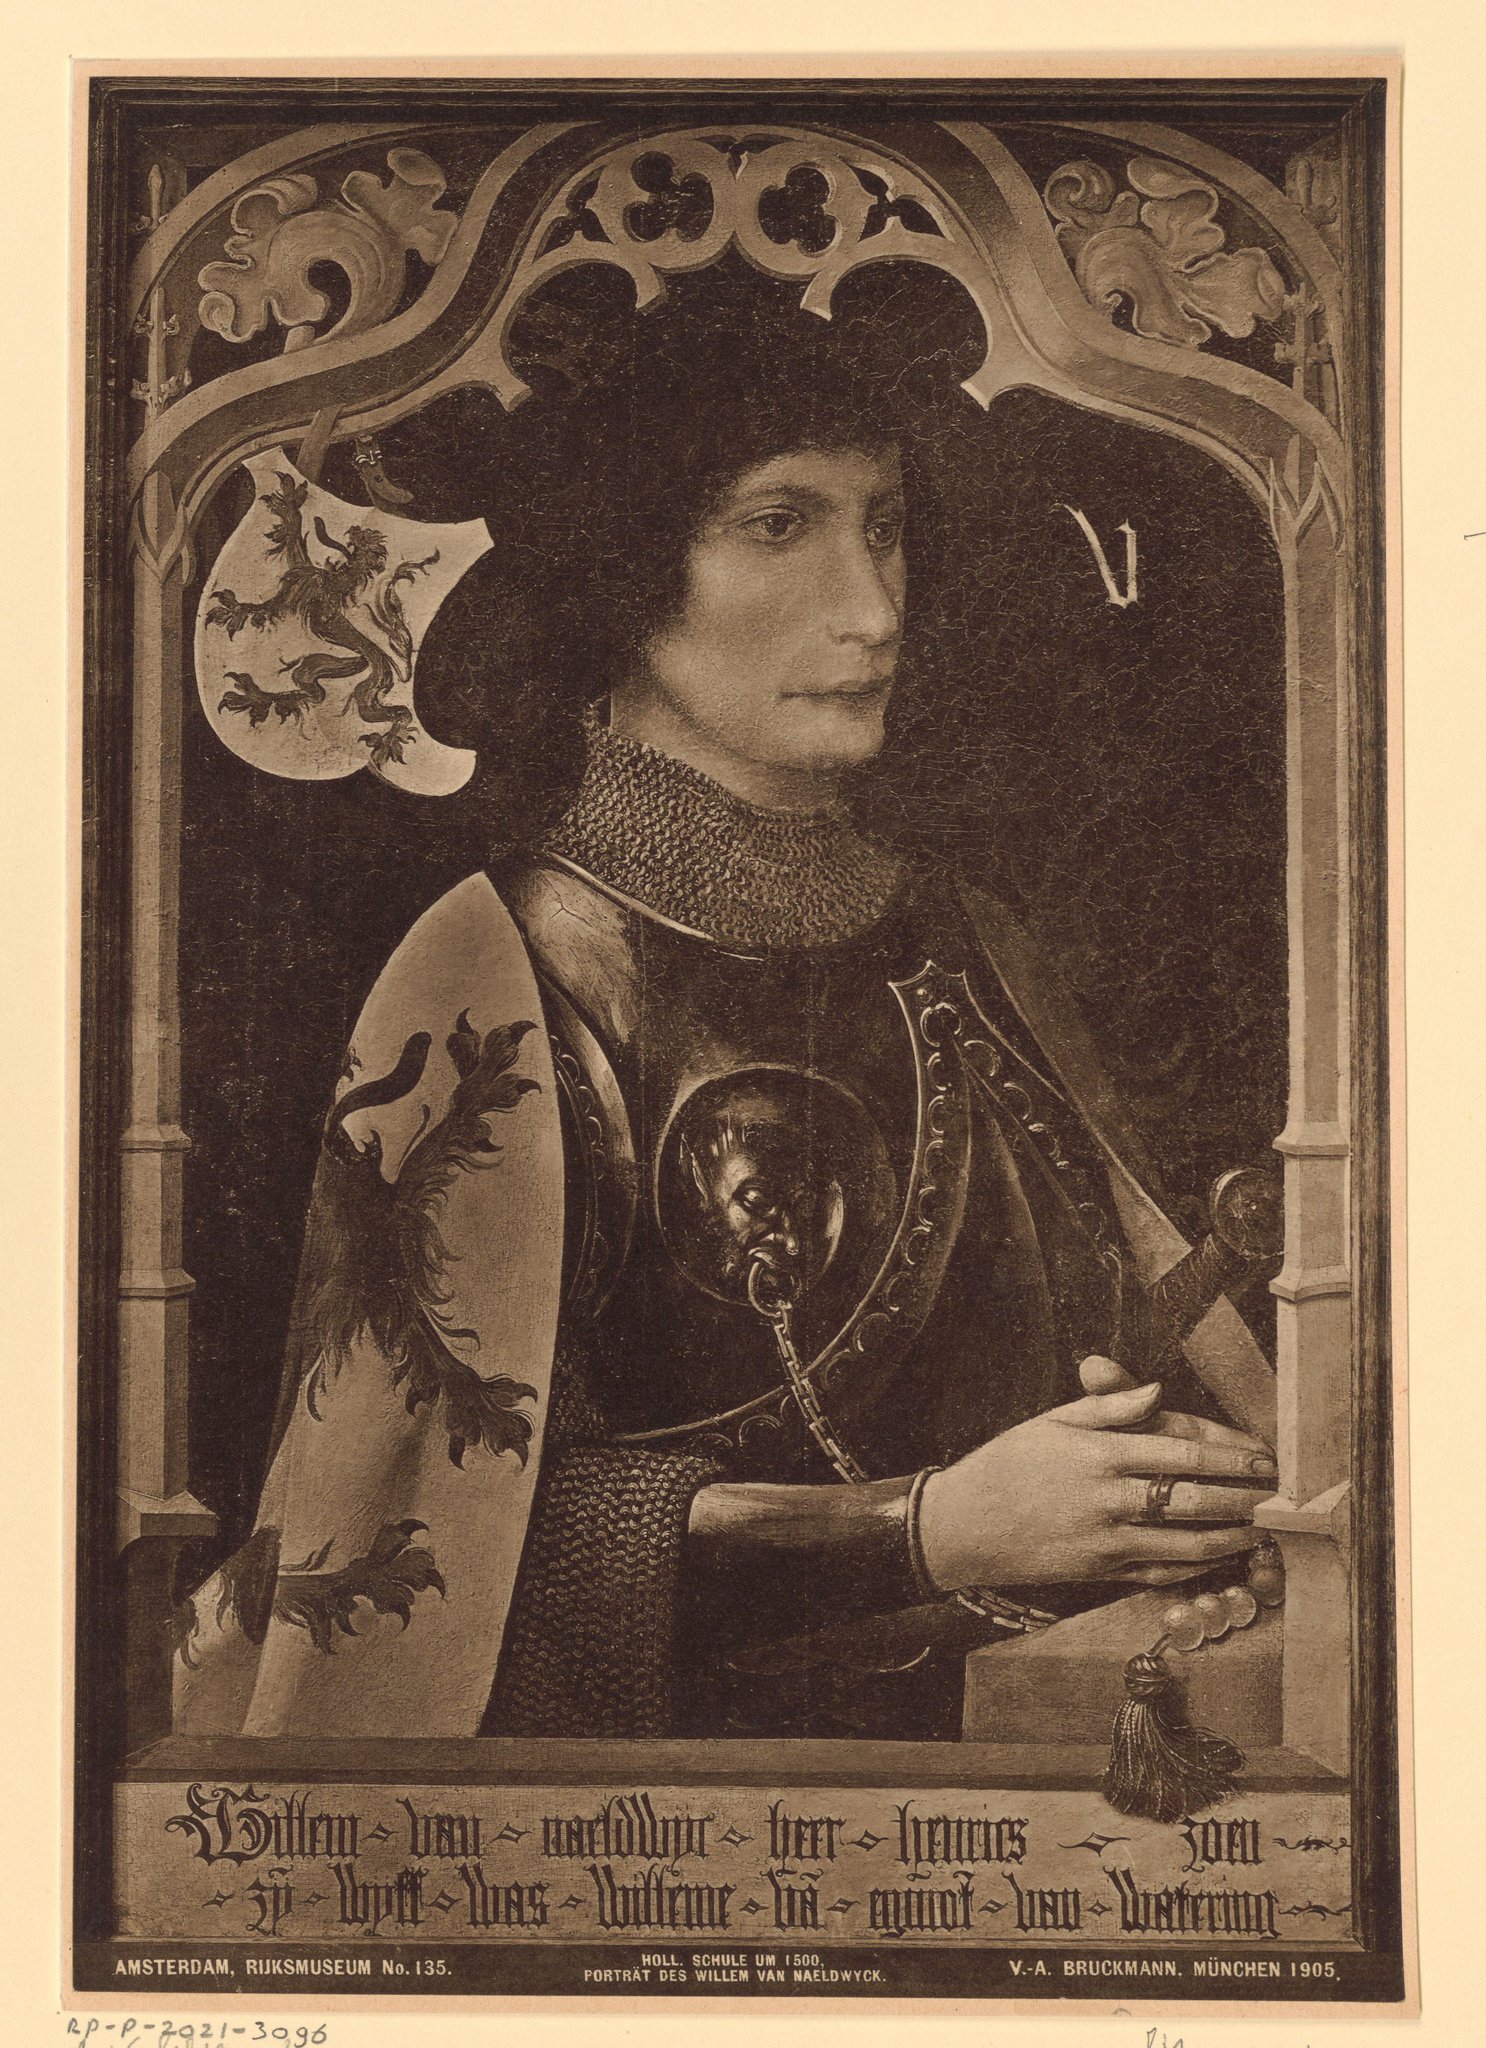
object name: photomechanical print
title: Portret van Willem II van Naaldwijk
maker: Anonymous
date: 1905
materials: paper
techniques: photograph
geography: munich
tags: commander-in-chief, general, marshal, historical persons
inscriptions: collector's mark: Lugt 2228